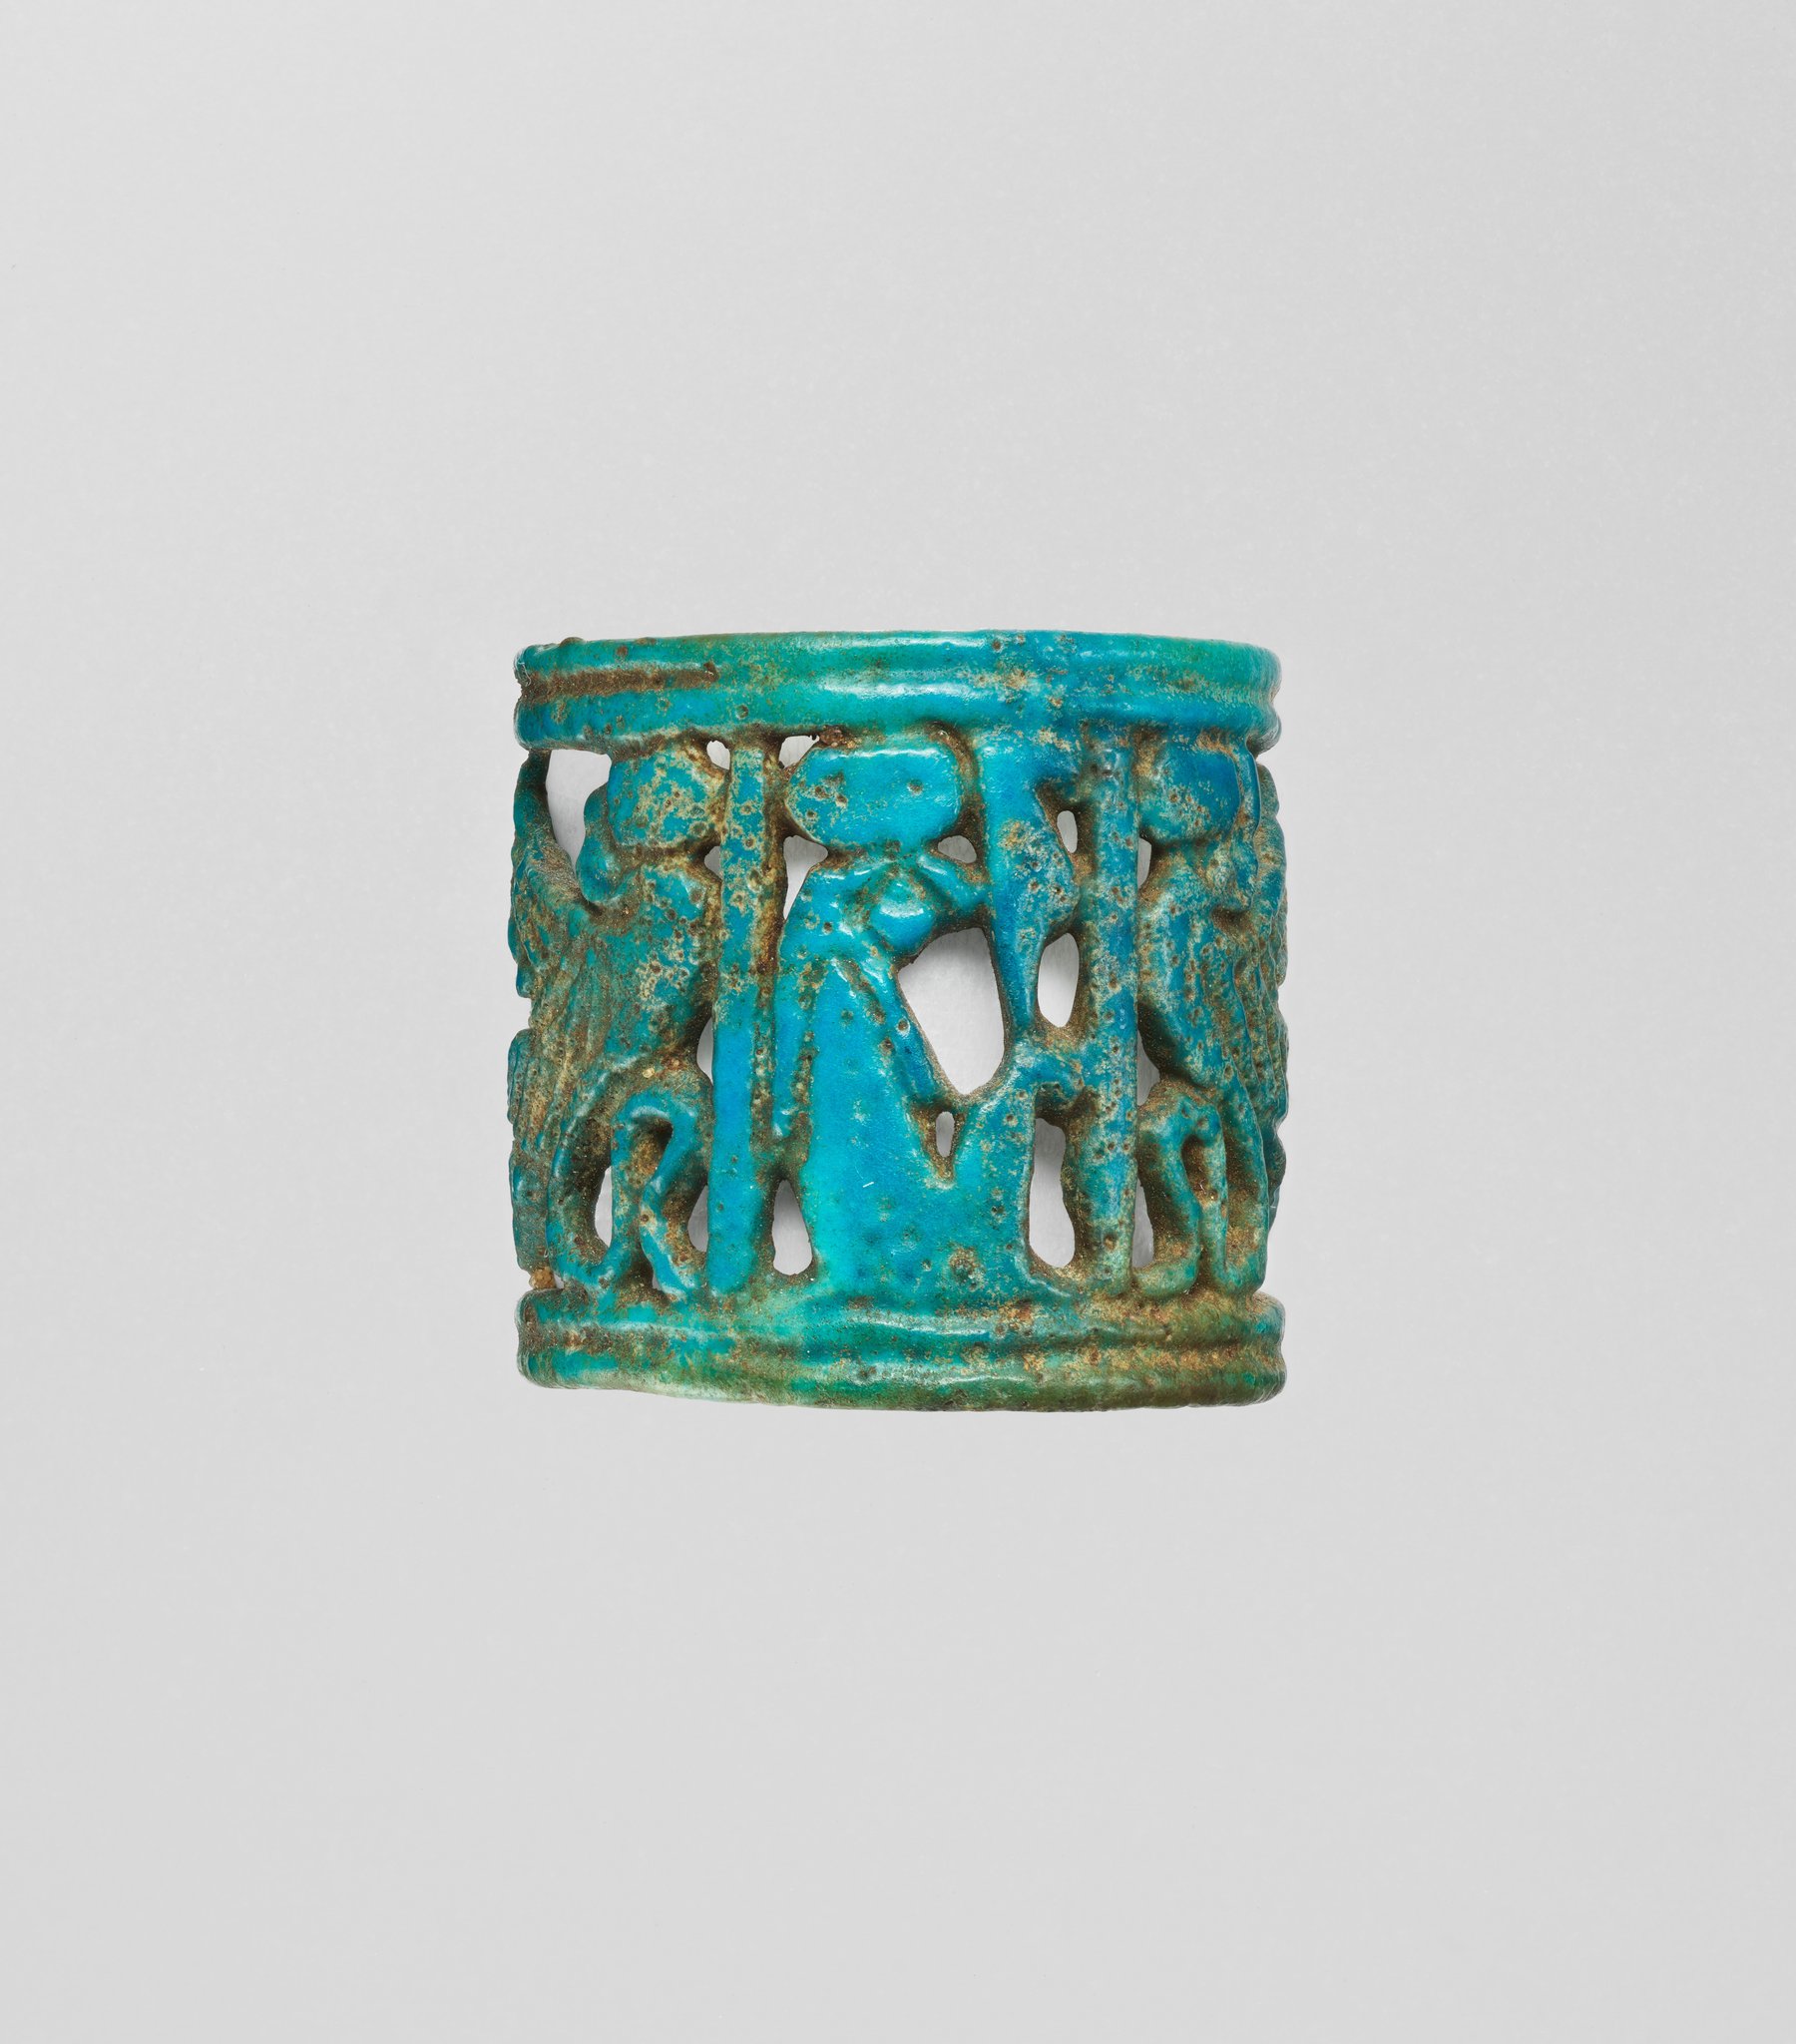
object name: ring, openwork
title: Openwork Ring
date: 1070-712 BCE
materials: faience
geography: egypt